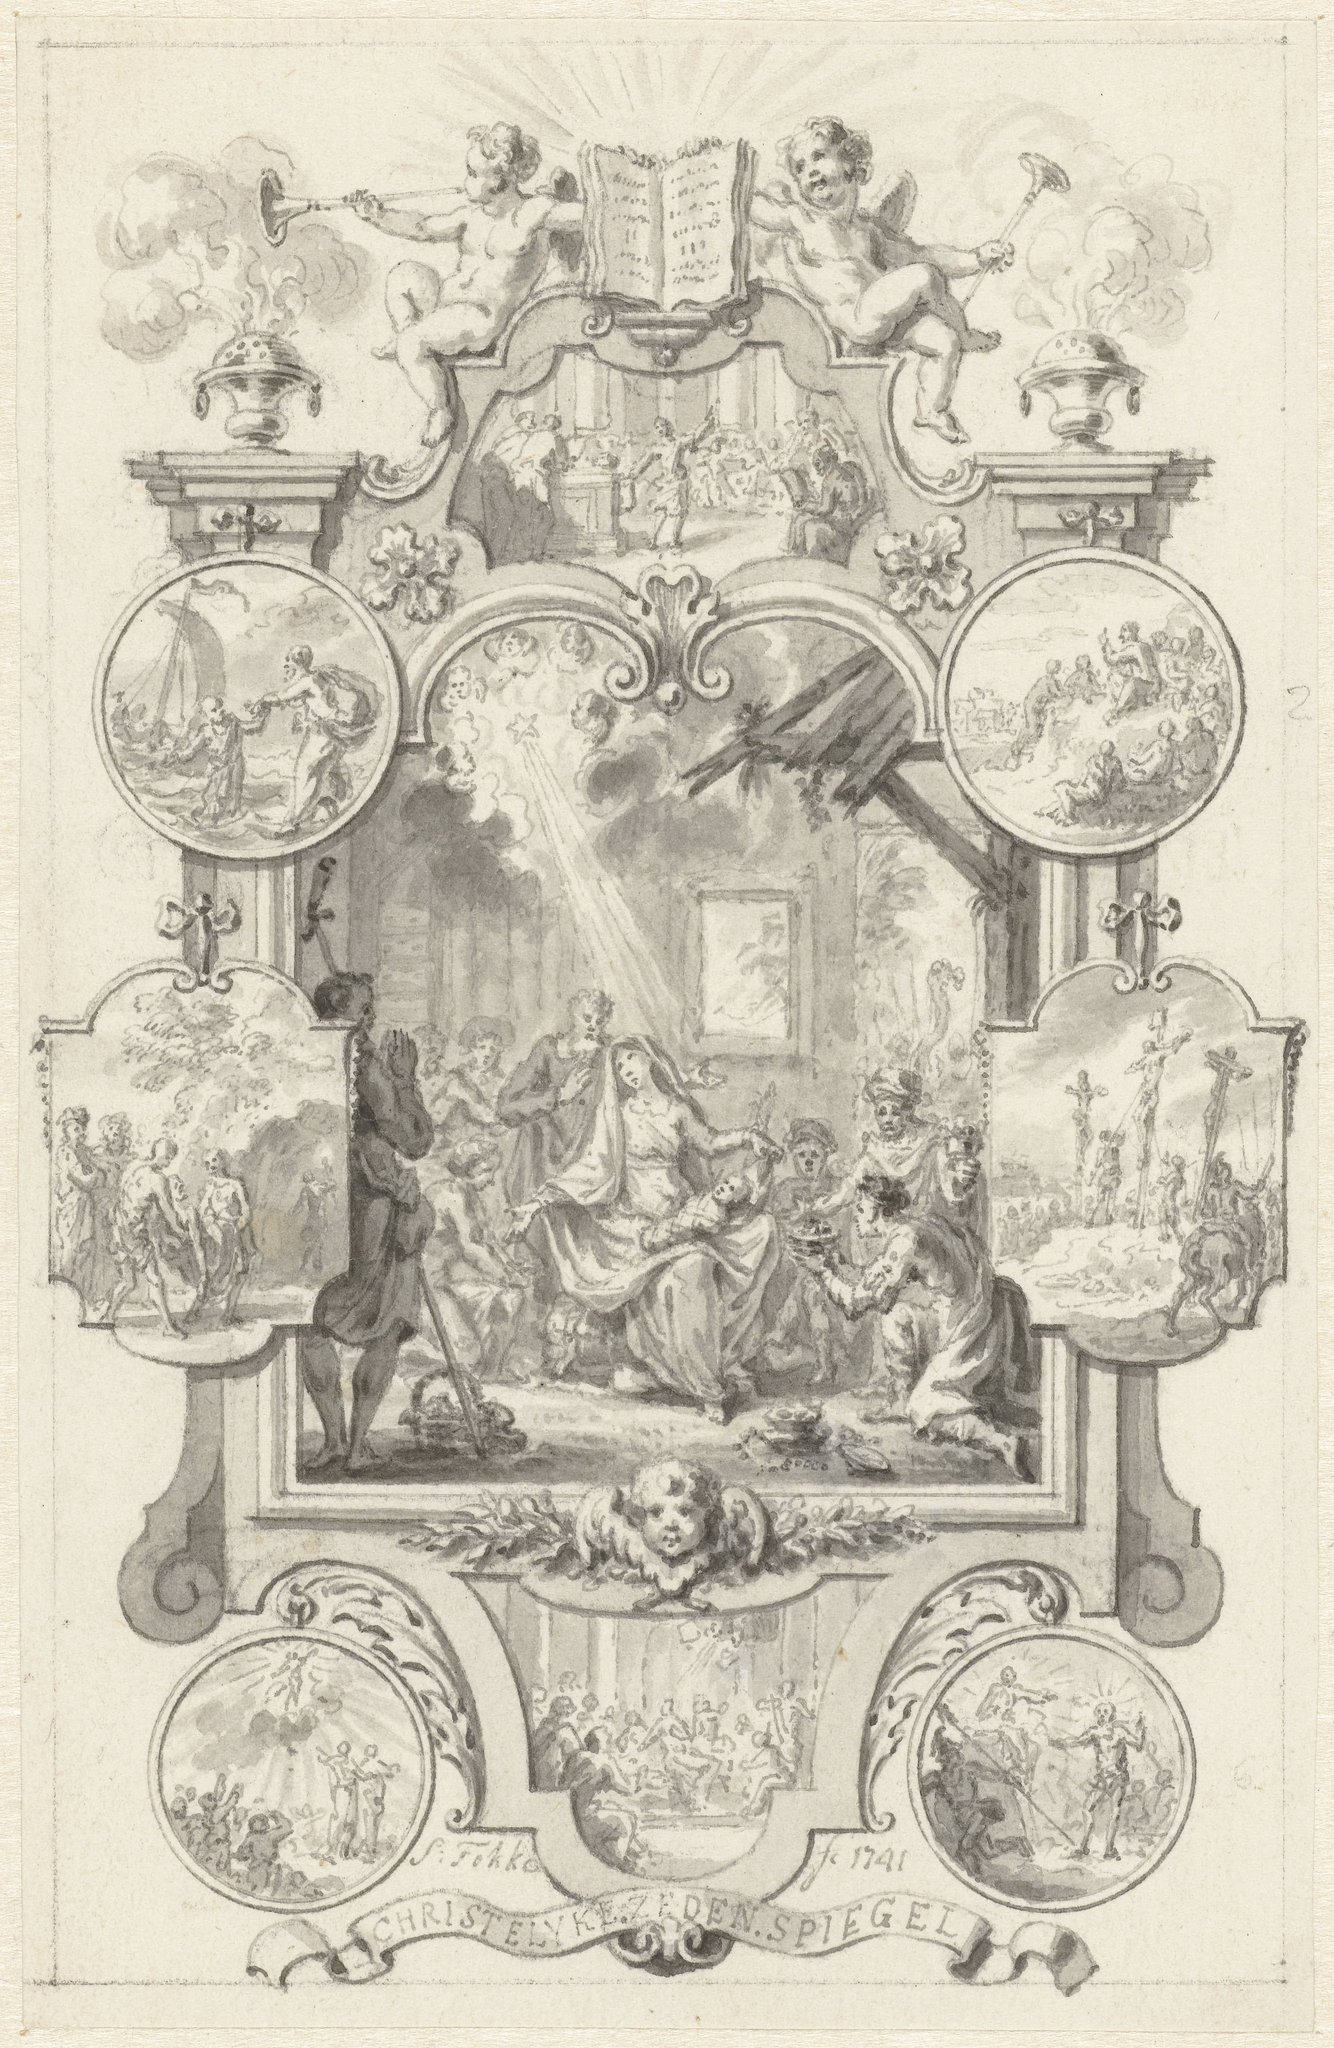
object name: drawing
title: Ontwerp voor titelblad: Christelyke Zeden Spiegel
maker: simon fokke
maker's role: draughtsman, print maker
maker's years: 1712-1784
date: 1741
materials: ink, paper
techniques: brush, pen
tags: adoration of the kings: the wise men present their gifts to the christ-child (gold, frankincense and myrrh)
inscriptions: inscription: ‘Christelyke Zeden Spiegel’, date: ‘1741’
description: Ontwerp voor titelblad: Christelyke Zeden Spiegel: de aanbidding der koningen, omringd door bijbelse voorstellingen.